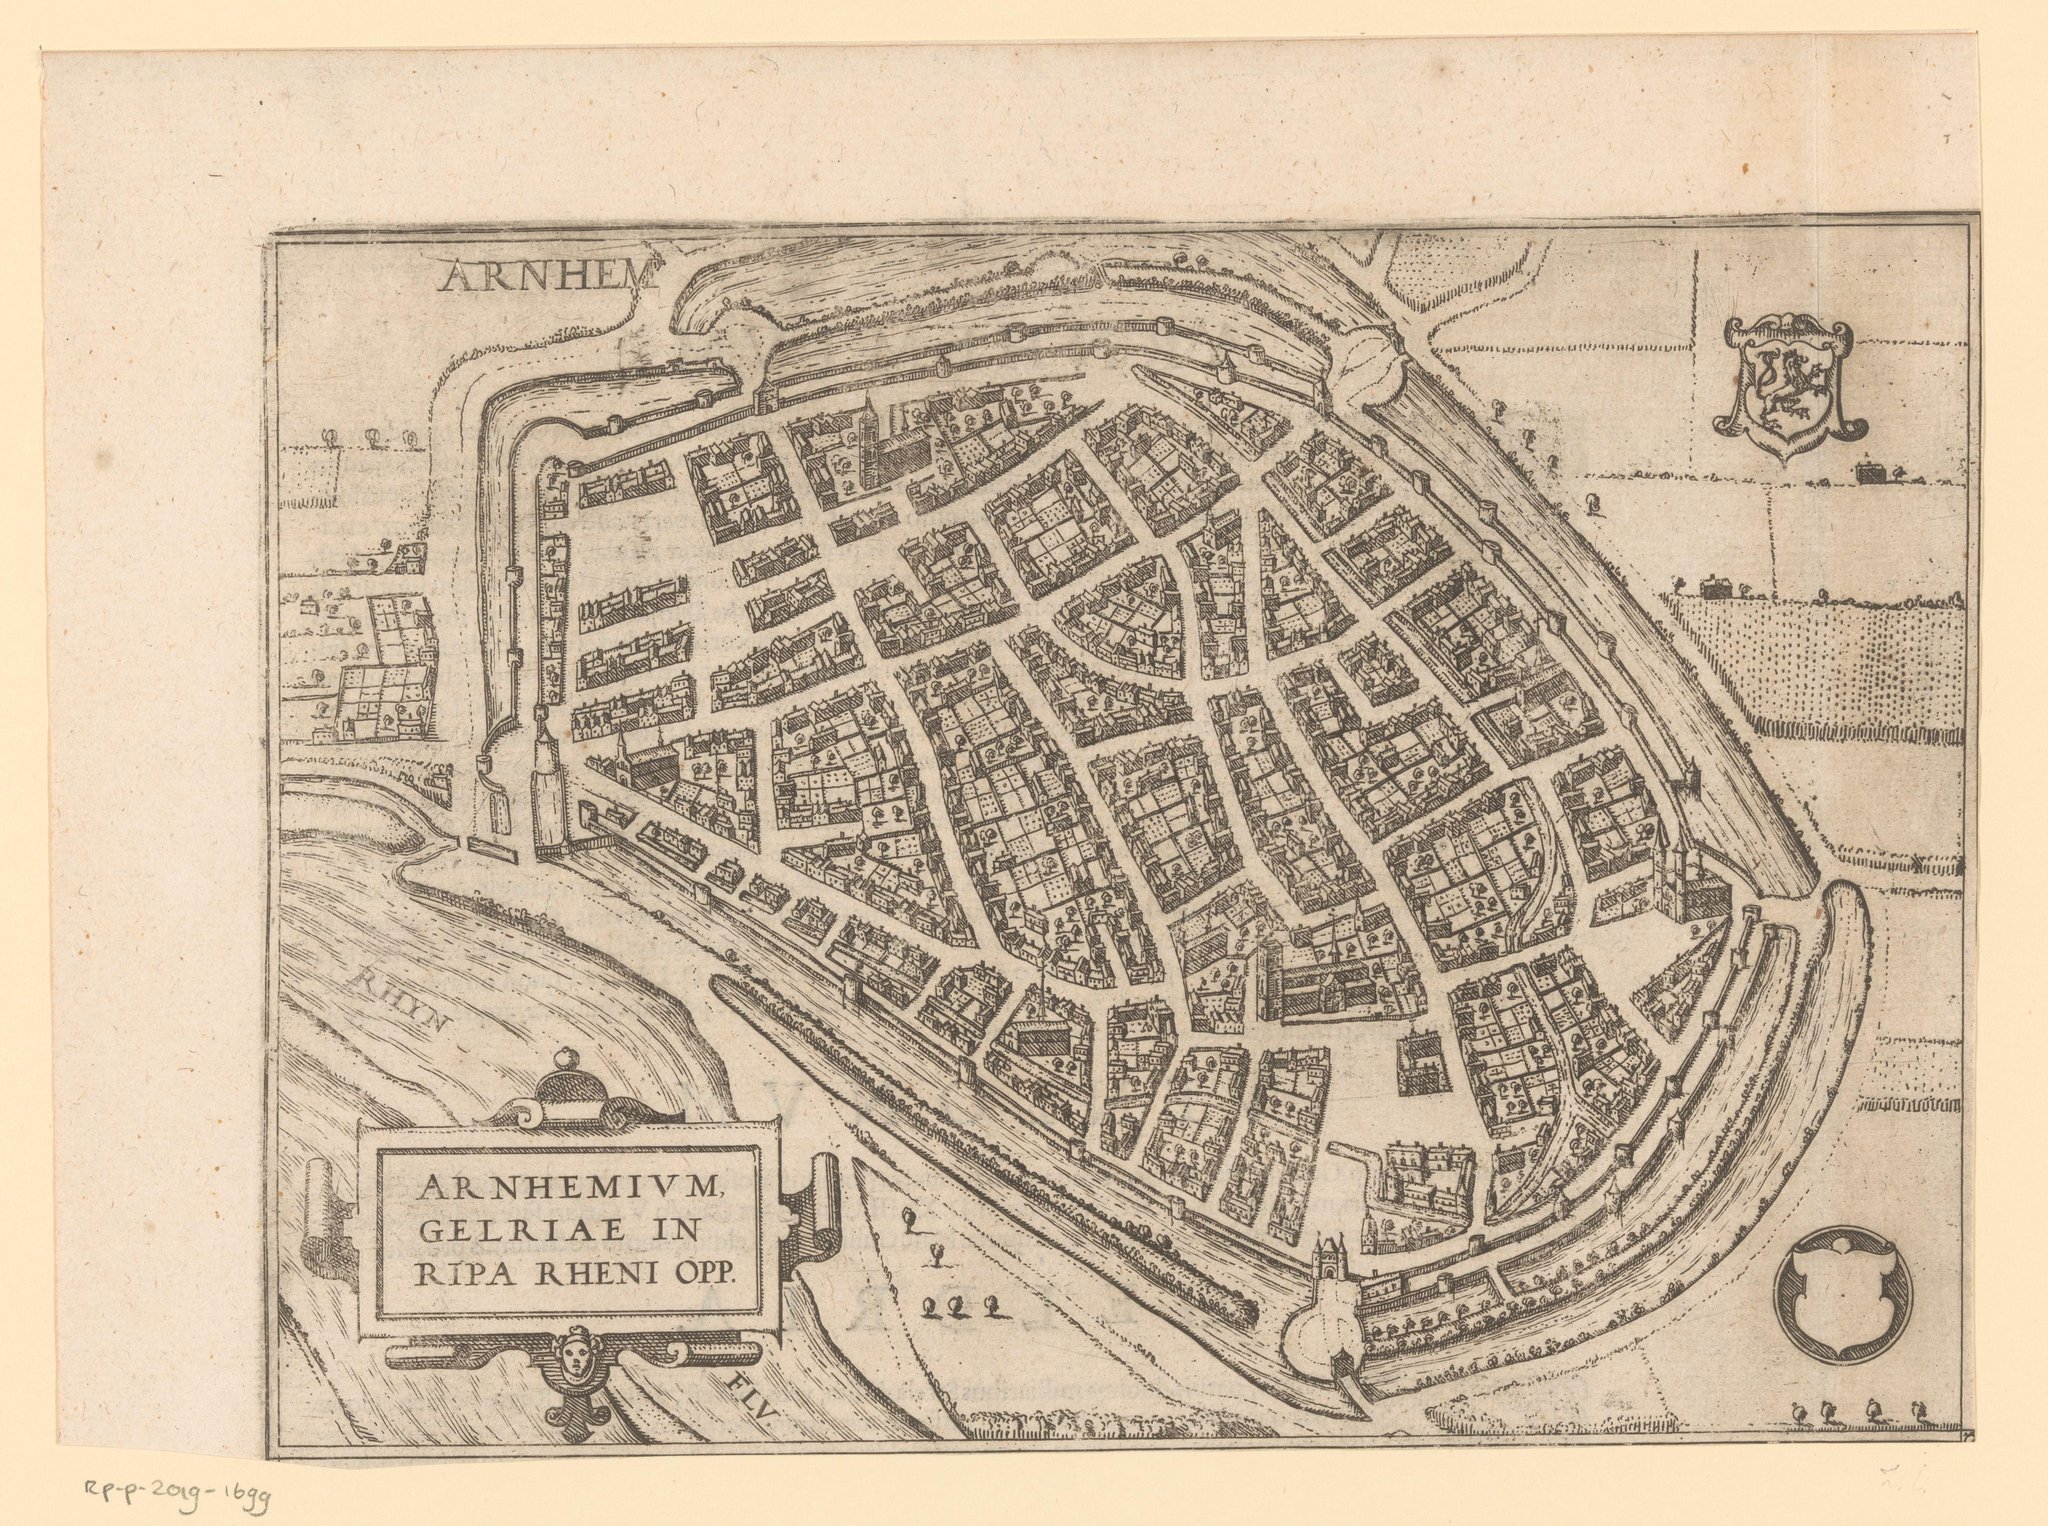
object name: area plan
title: Plattegrond van Arnhem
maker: Anonymous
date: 1581-1657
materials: paper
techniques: etching, letterpress printing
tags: maps of cities, arnhem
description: Prent verschenen in uitgaven van: Civitates orbis terrarum. En in: Theatrum urbium celebriorum totius Belgii. Amsterdam: Johannes Janssonius, 1657.